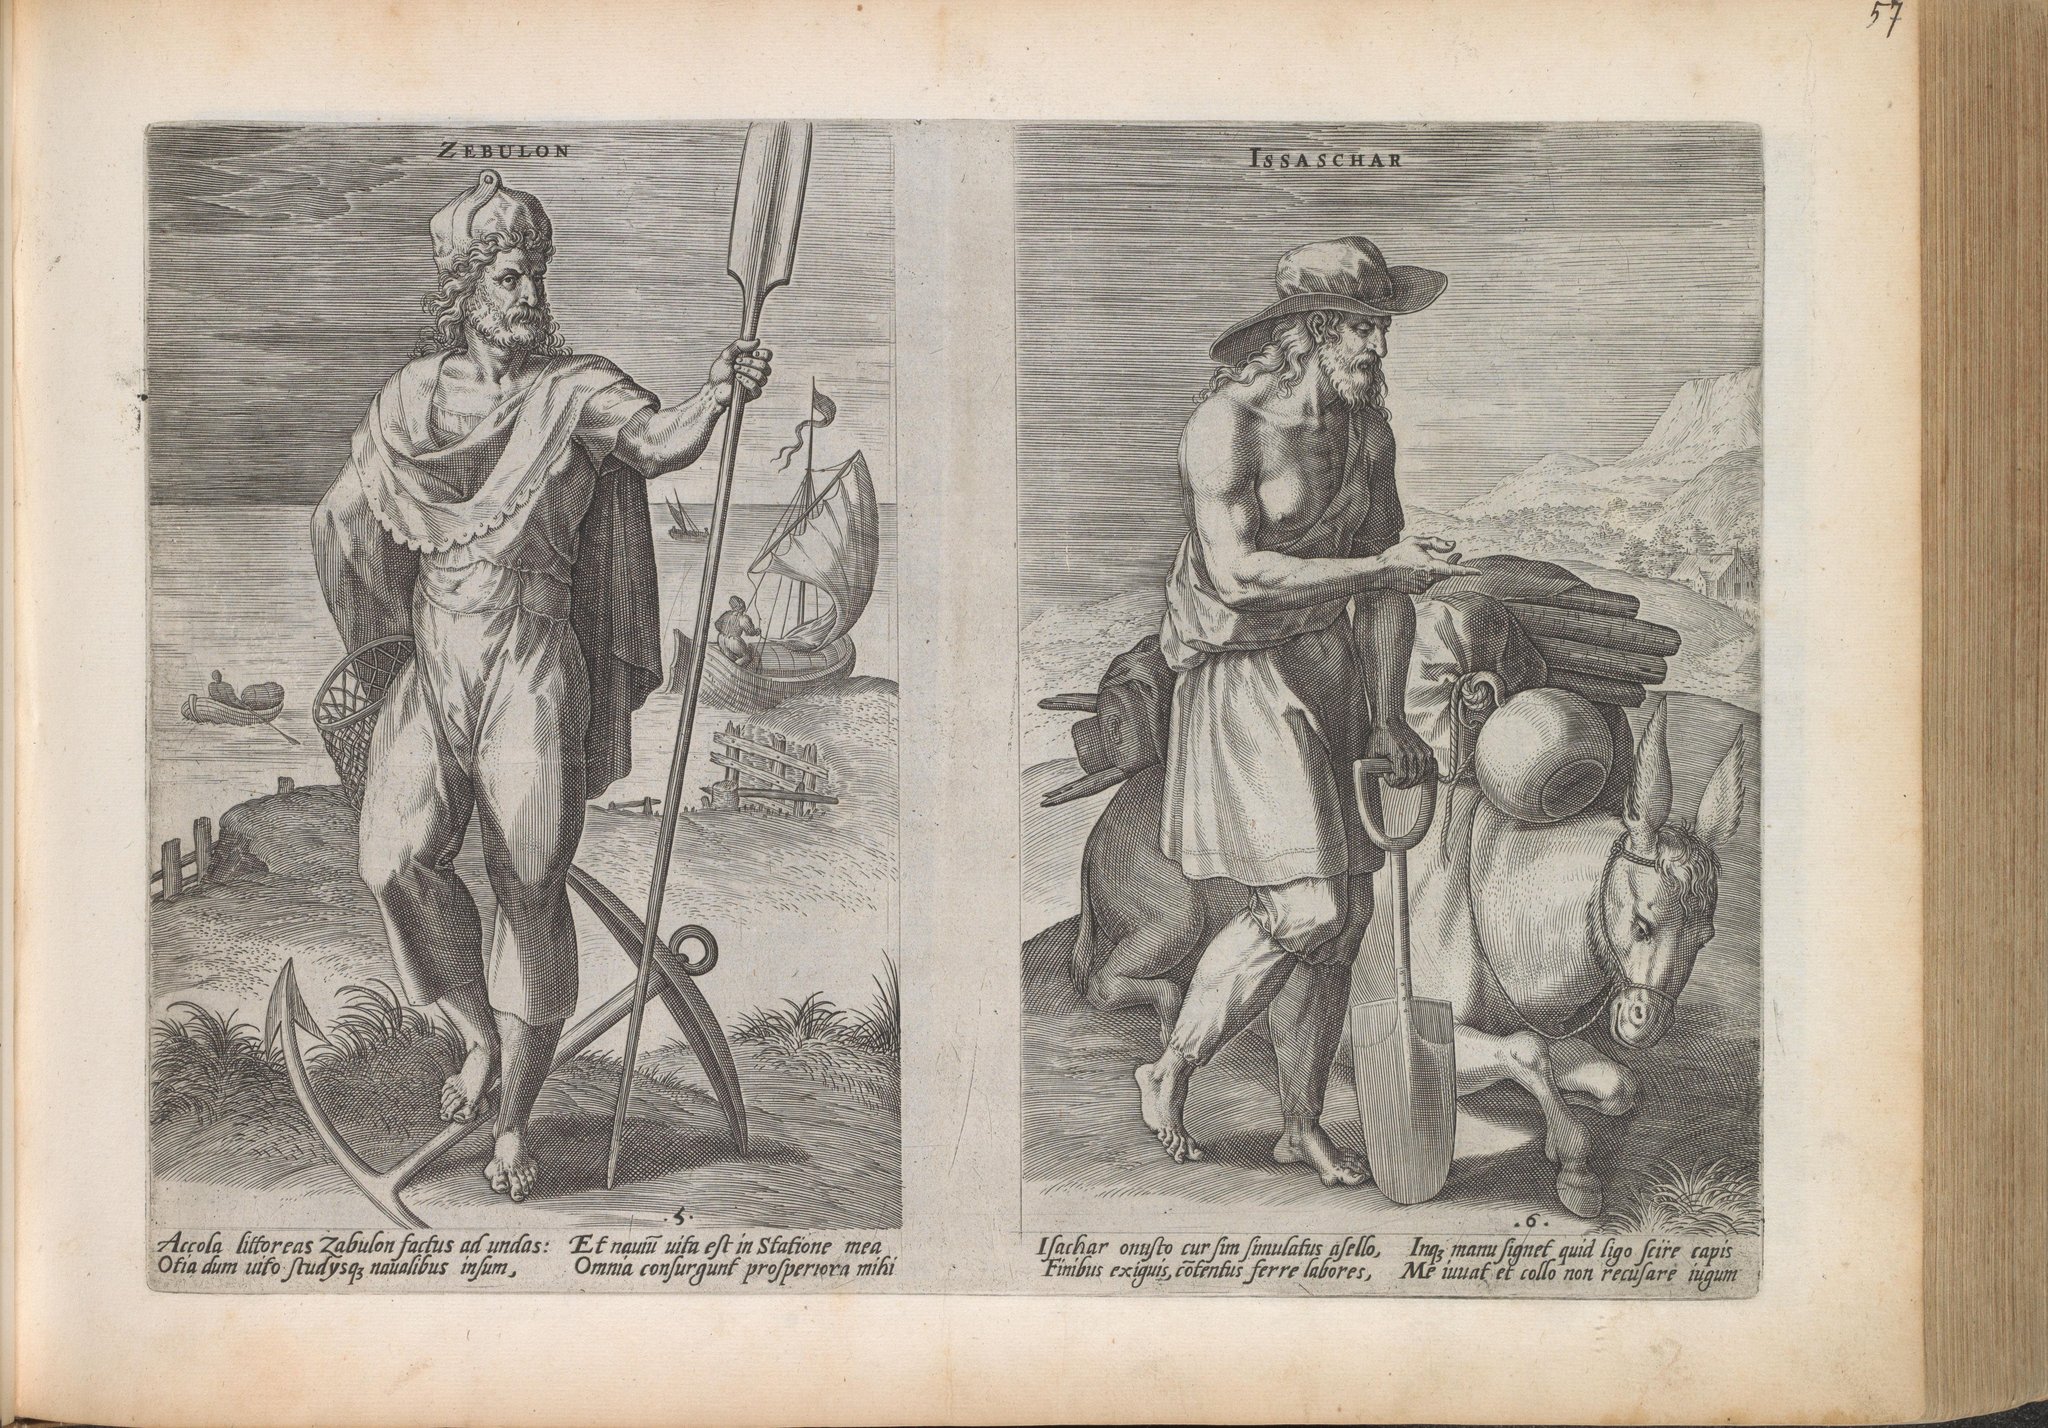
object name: album leaf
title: Theatrum Biblicum Hoc Est Historiae Sacrae Veteris et Novi Testamenti Tabulis Aeneis Expressae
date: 1585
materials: paper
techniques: engraving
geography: amsterdam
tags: 11i611(issaschar), 11i611(zebulon)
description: Links stamvader Zebulon, de tiende zoon van Jakob. Hij is gekleed als visser. Op de grond naast hem een anker. Op de achtergrond de zee en een strand, een verwijzing naar de woonplaats van Zebulon. Rechts stamvader Issachar, de negende zoon van Jakob. Naast hem ligt een ezel, een verwijzingen naar Issachar als een 'sterke ezel'. Onder de voorstellingen een verwijzing in het Latijn naar de Bijbeltekst. Deze prent maakt deel uit van een album.